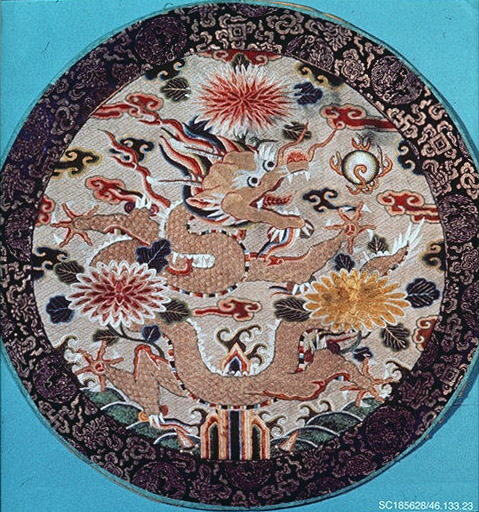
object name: badge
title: Festival badge with five-clawed dragon surrounded by chrysanthemums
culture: chinese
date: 1601-1633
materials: textile, silk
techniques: embroidery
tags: dragons